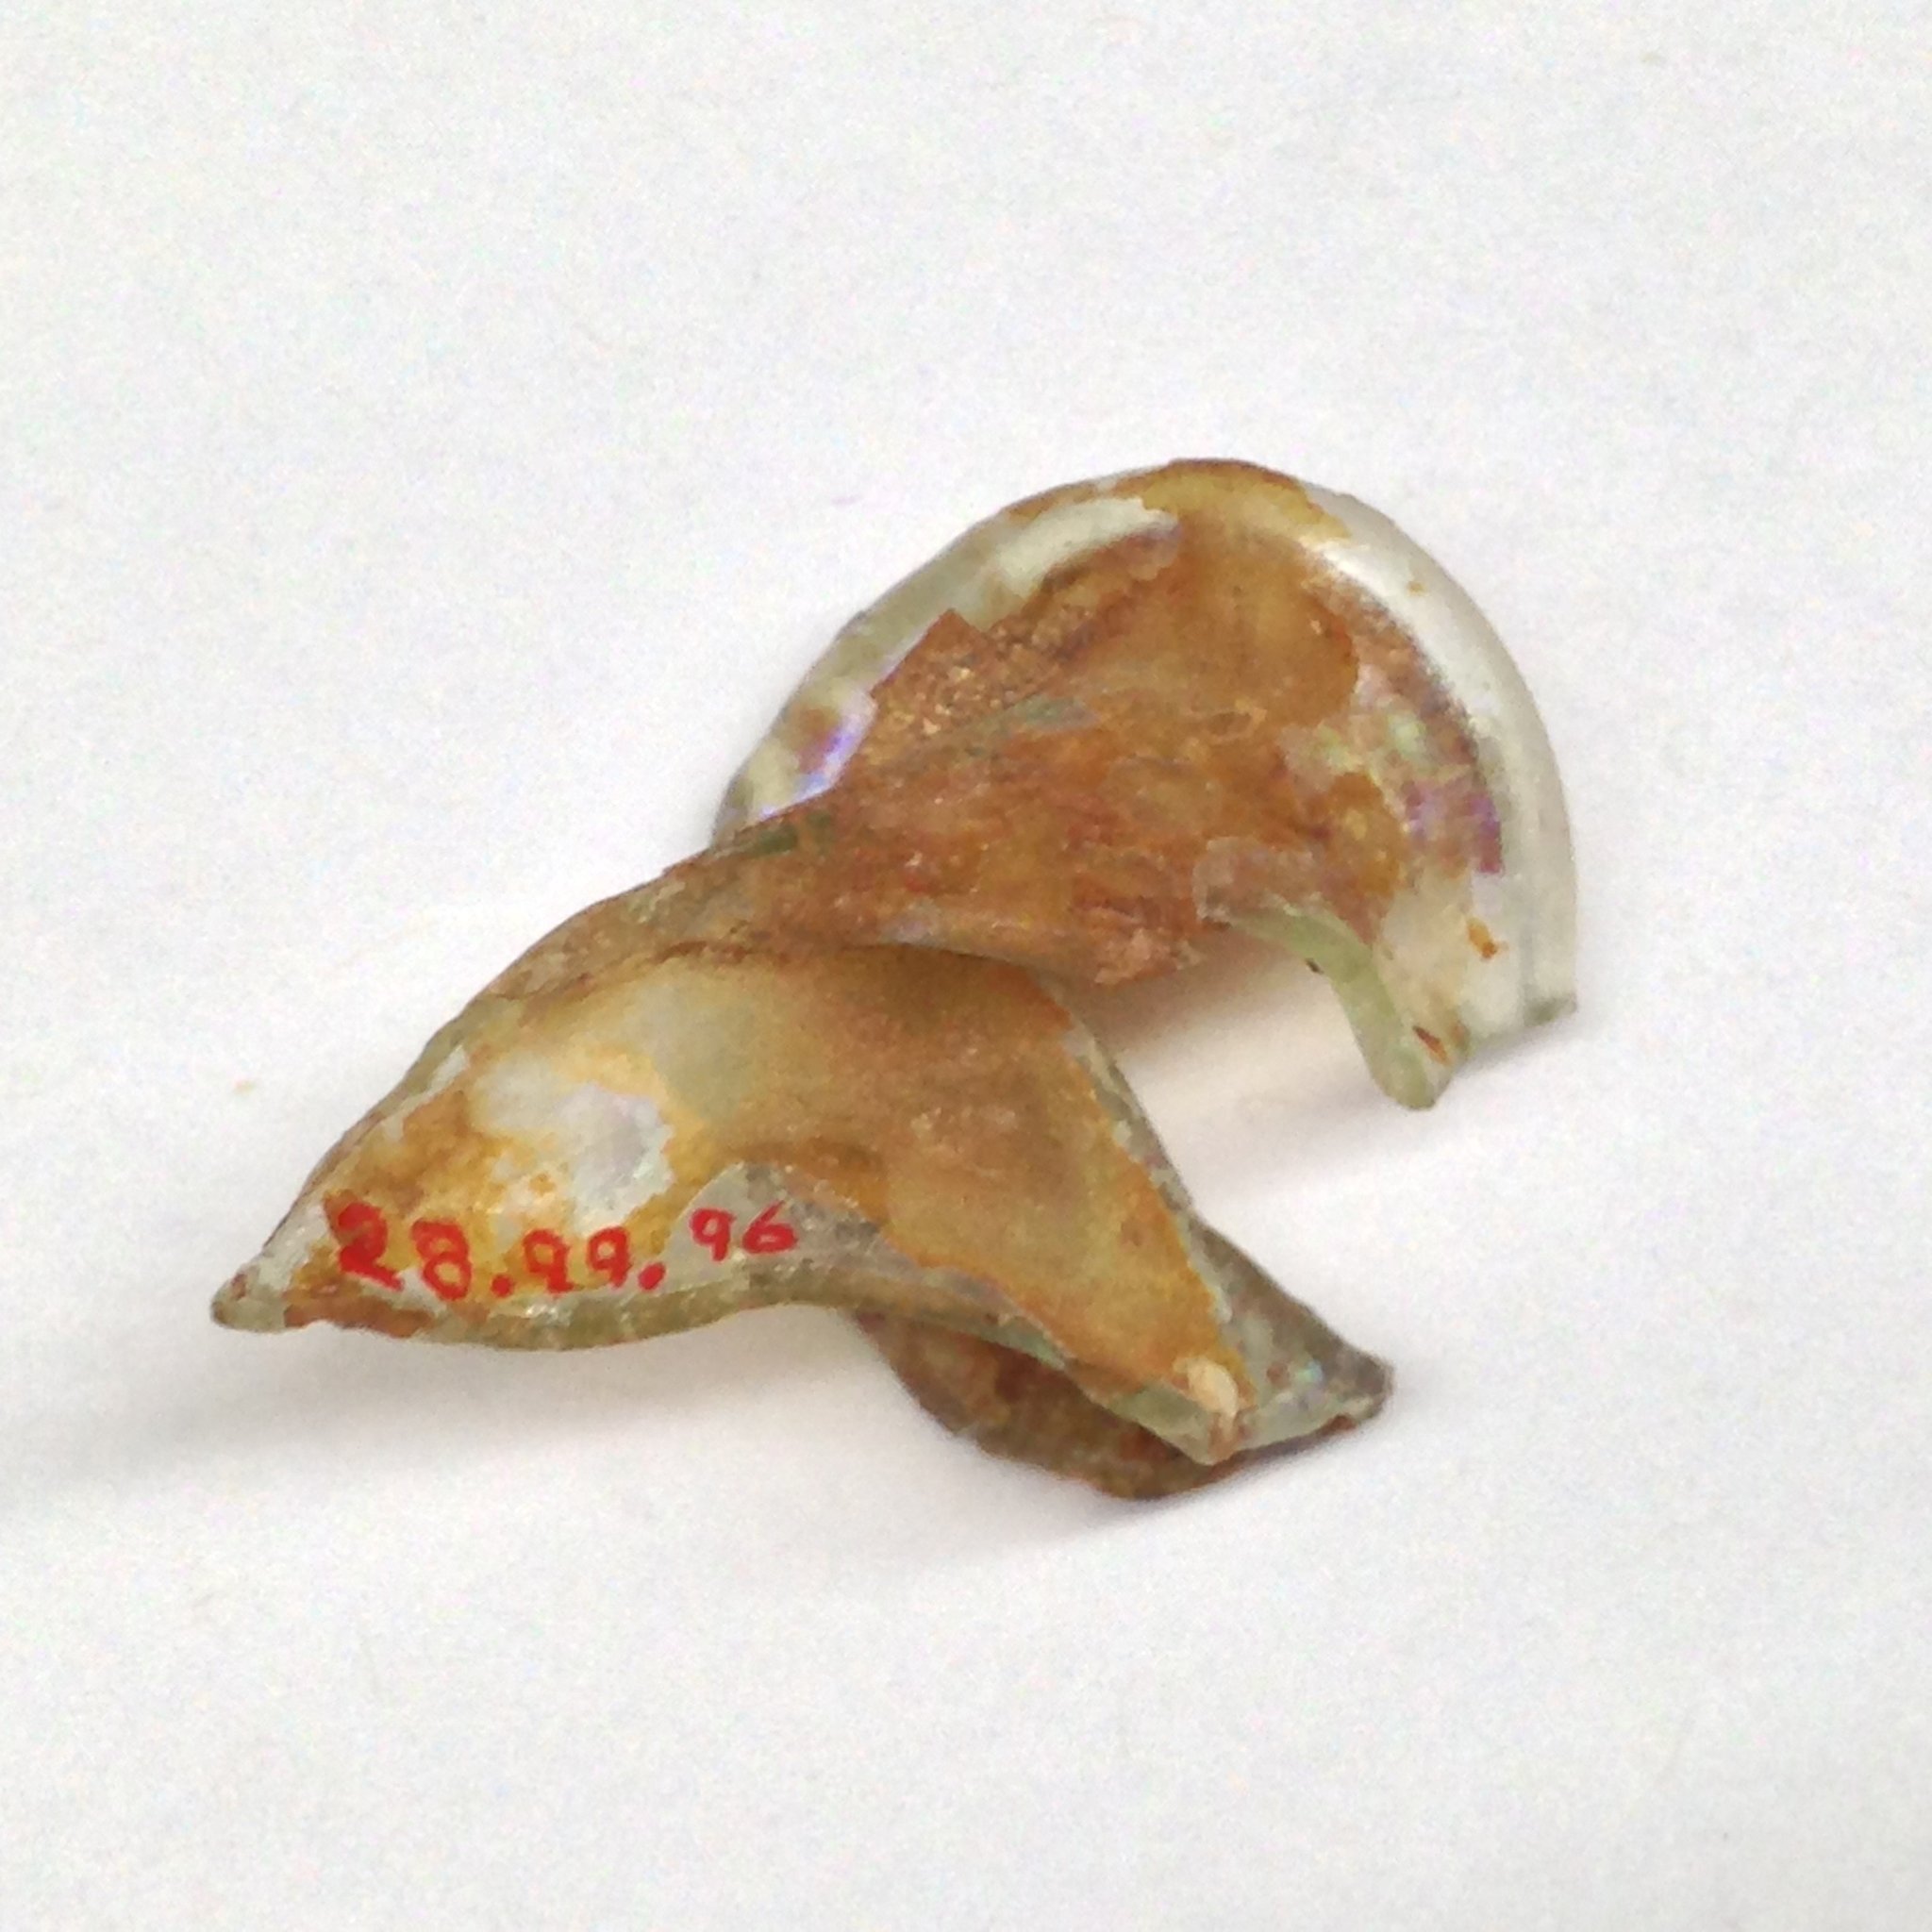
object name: fragment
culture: european or middle eastern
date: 1150-1250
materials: ceramic, glass